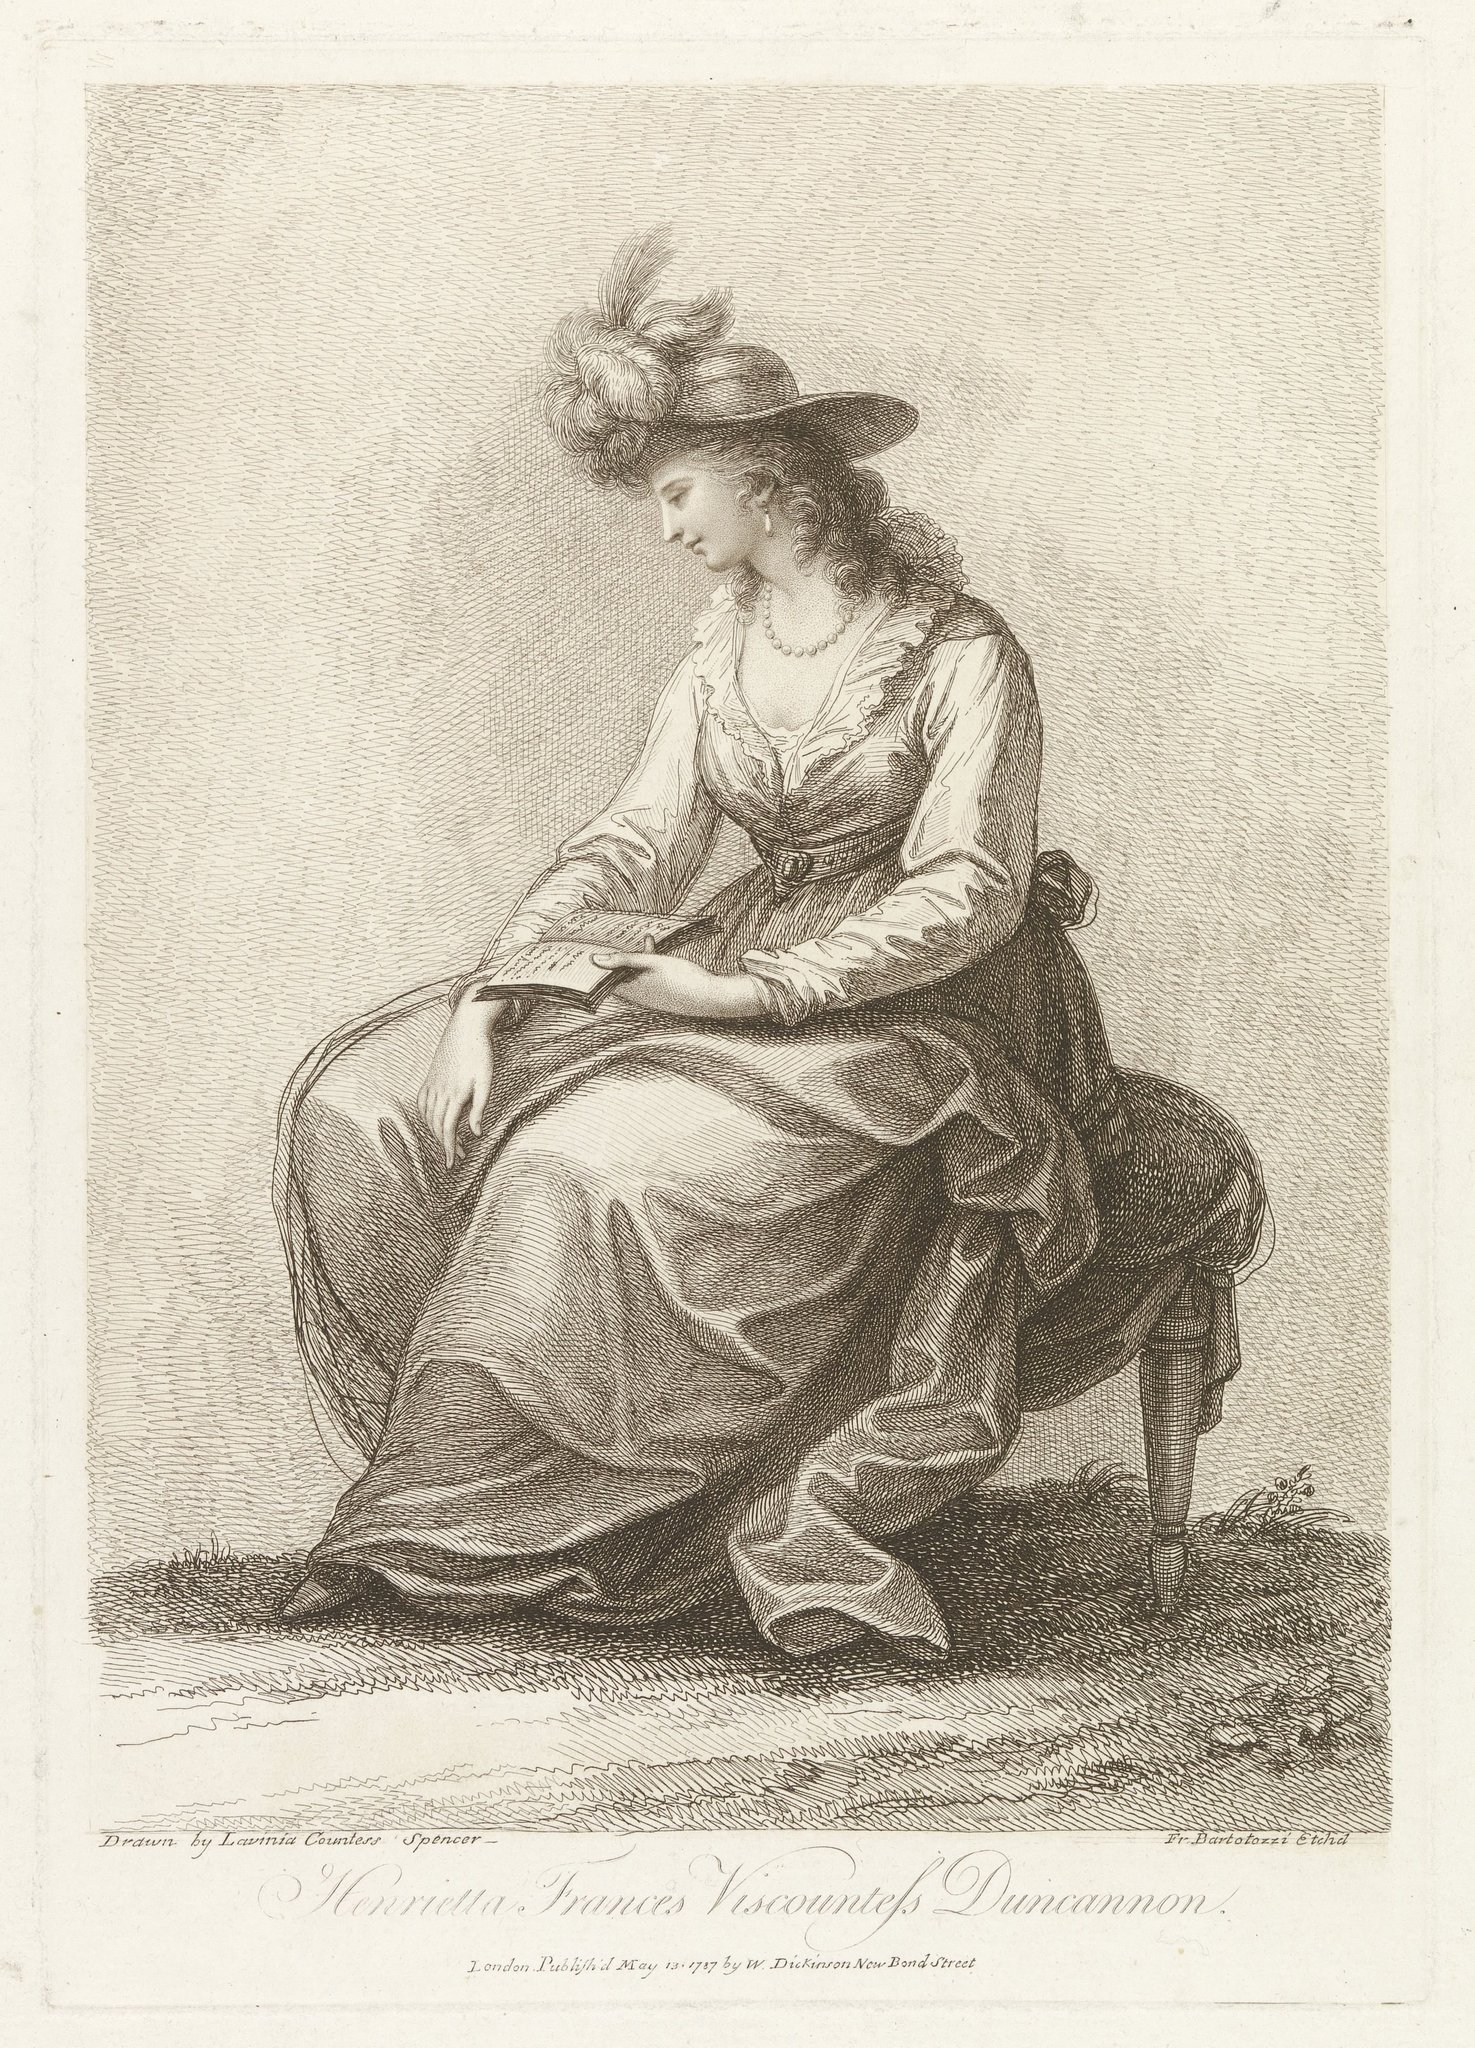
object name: print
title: Portret van Henrietta Ponsonby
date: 1781-1815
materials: paper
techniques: engraving, etching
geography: italy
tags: henrietta ponsonby (gravin van bessborough), historical persons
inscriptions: collector's mark: Lugt 2165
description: Portret van Henrietta Ponsonby zittend op een bankje met een boek in haar hand.